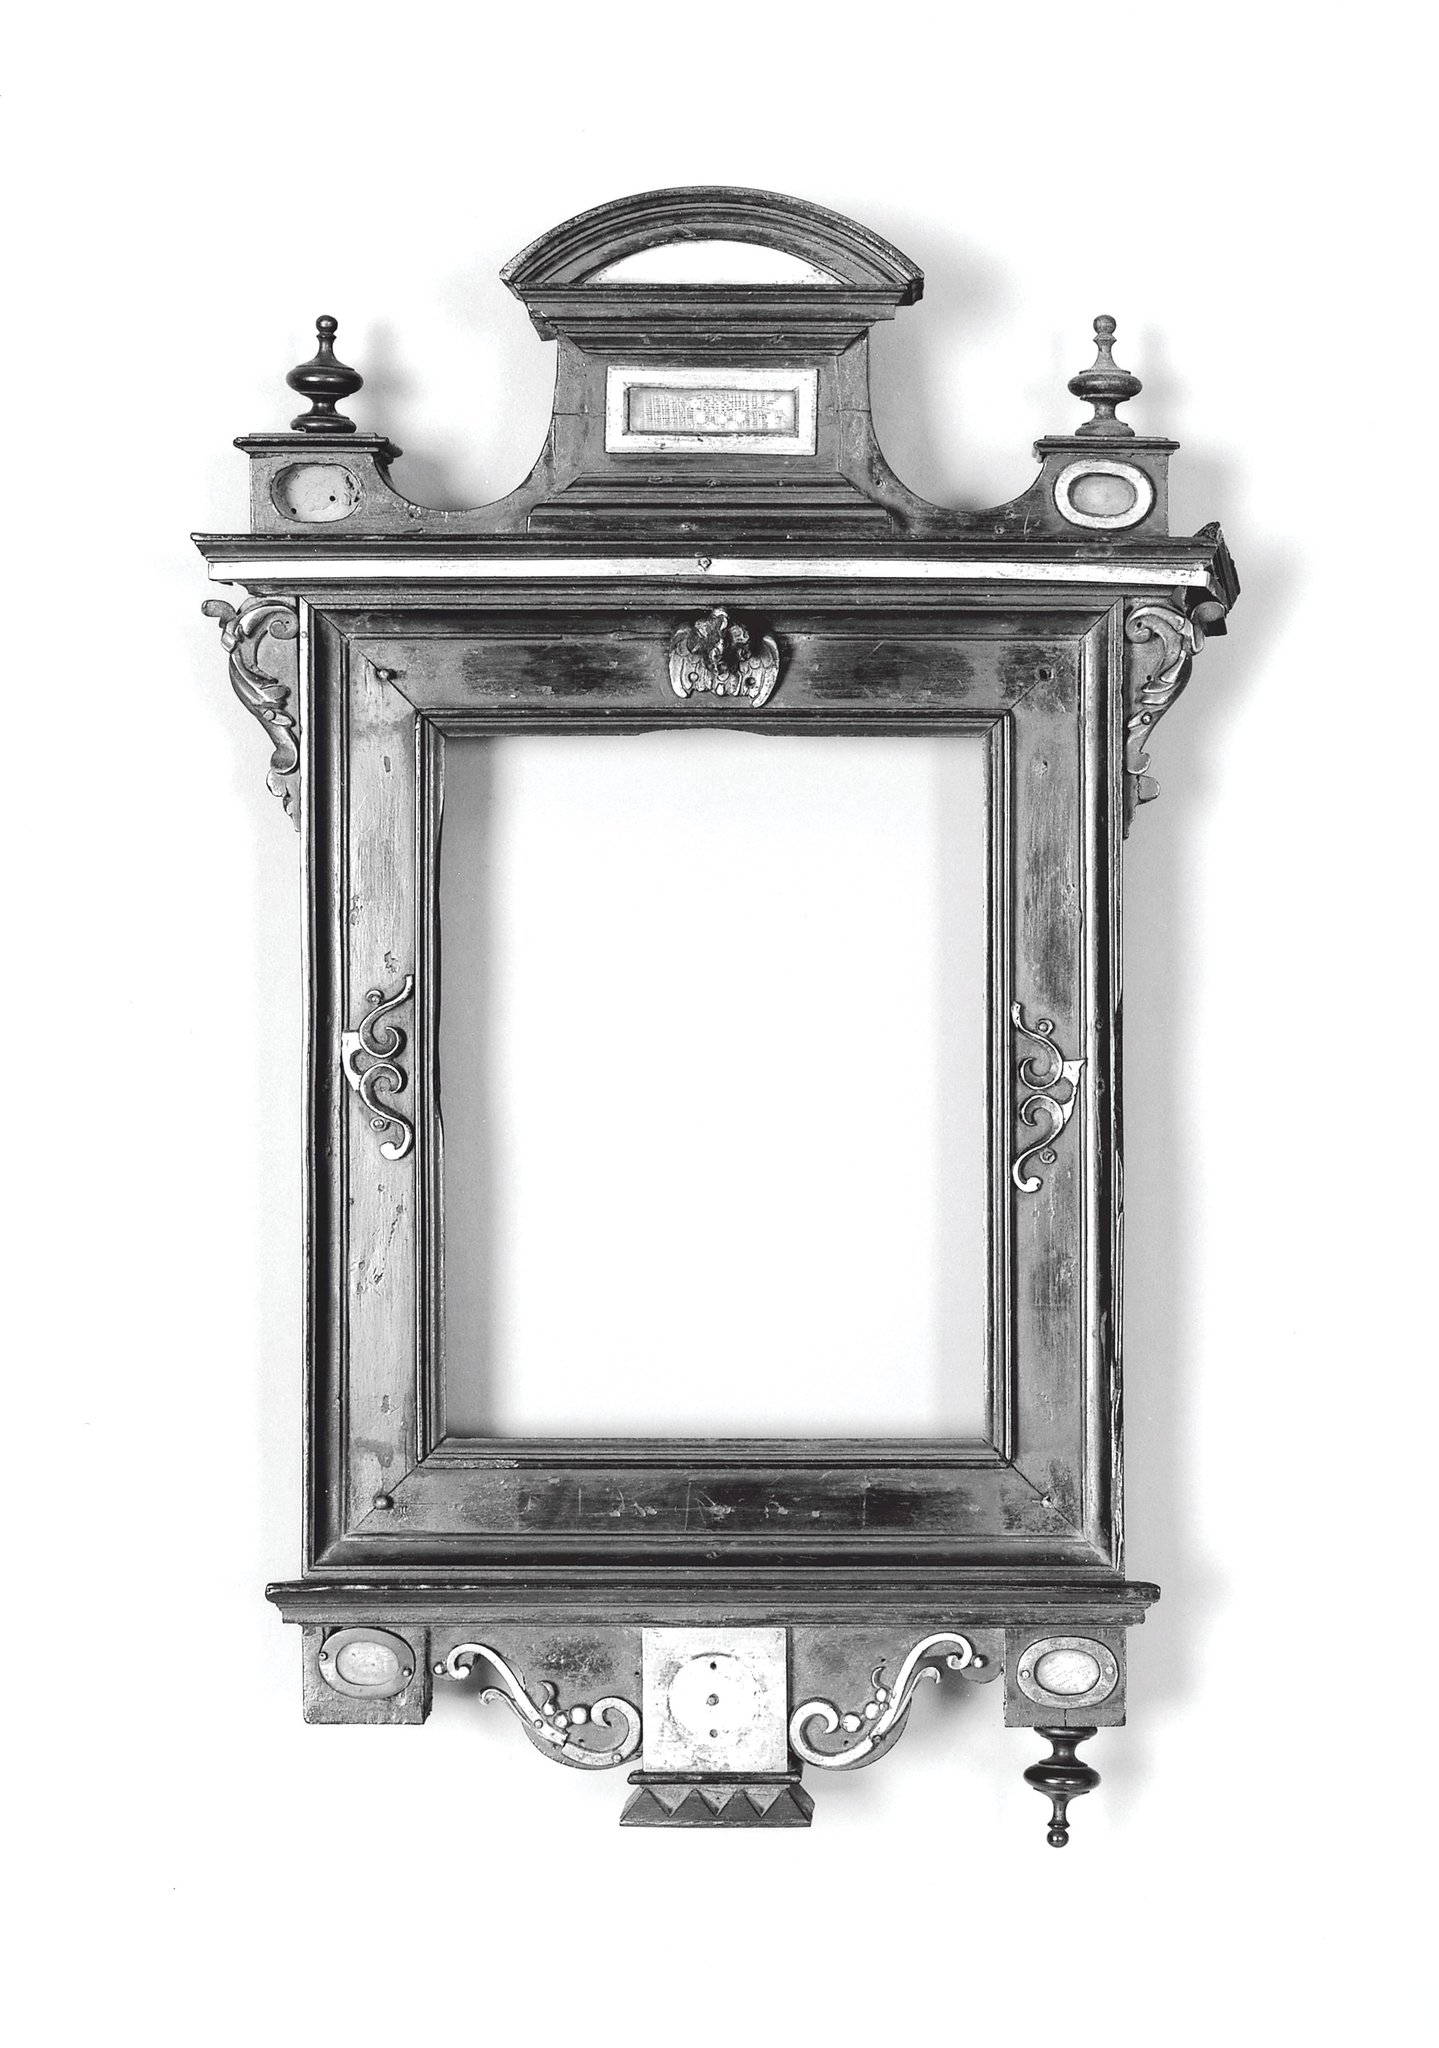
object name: frame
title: Reliquary with tabernacle frame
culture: austrian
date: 1605-1610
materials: wood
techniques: veneering